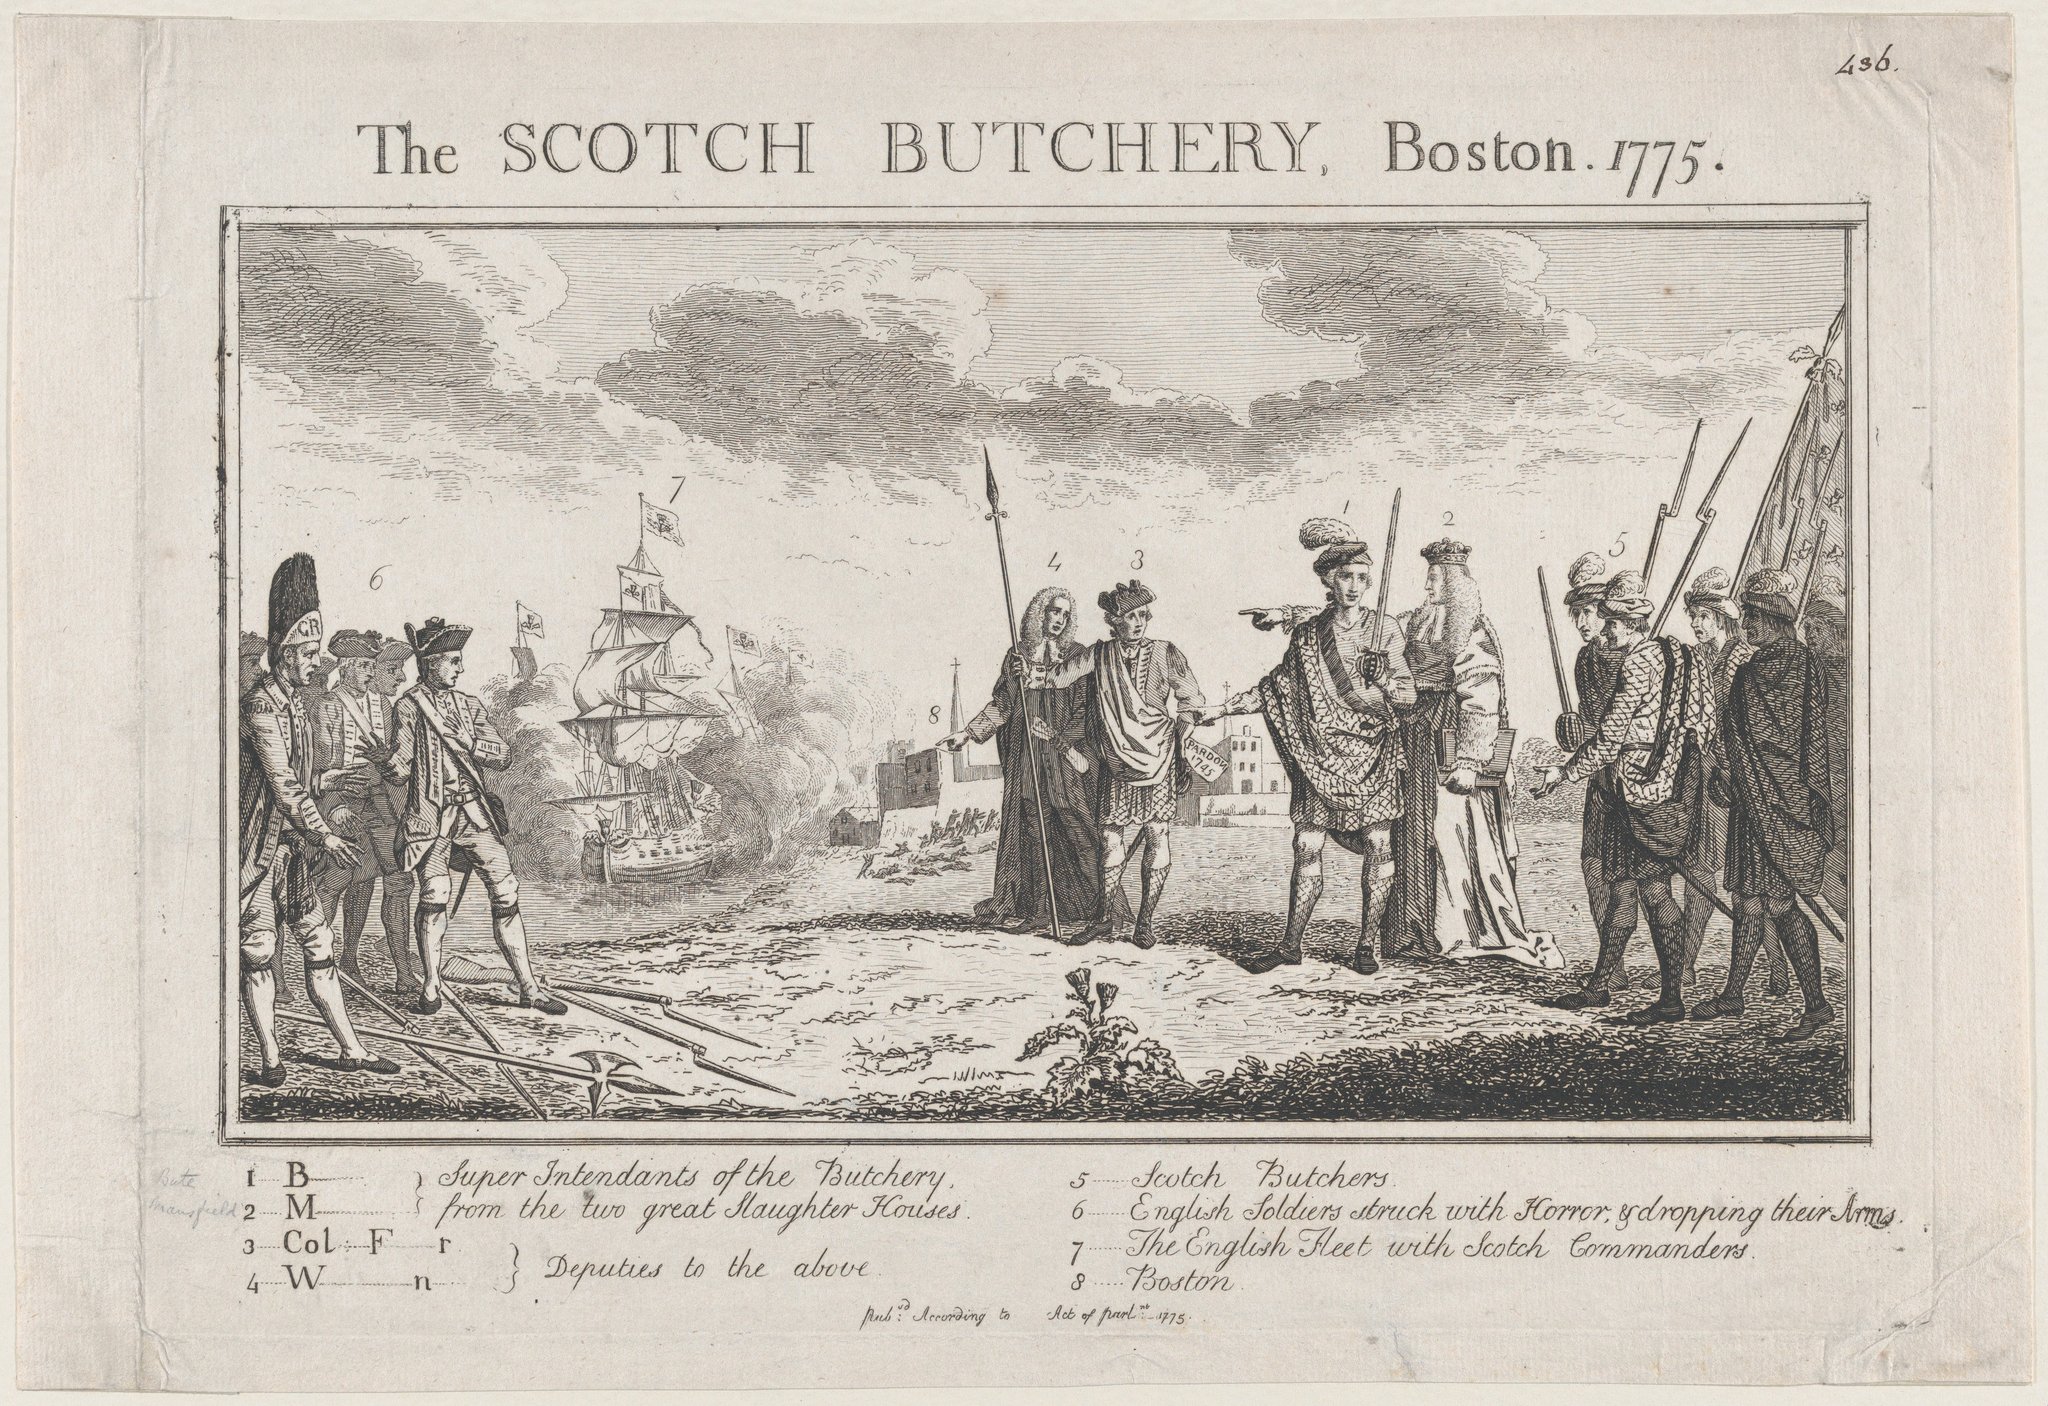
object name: print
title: The Scotch Butchery, Boston, 1775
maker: anonymous, british, 18th century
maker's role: artist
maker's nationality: british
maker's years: 1700-1800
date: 1775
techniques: engraving, etching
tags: american revolution,men,ships